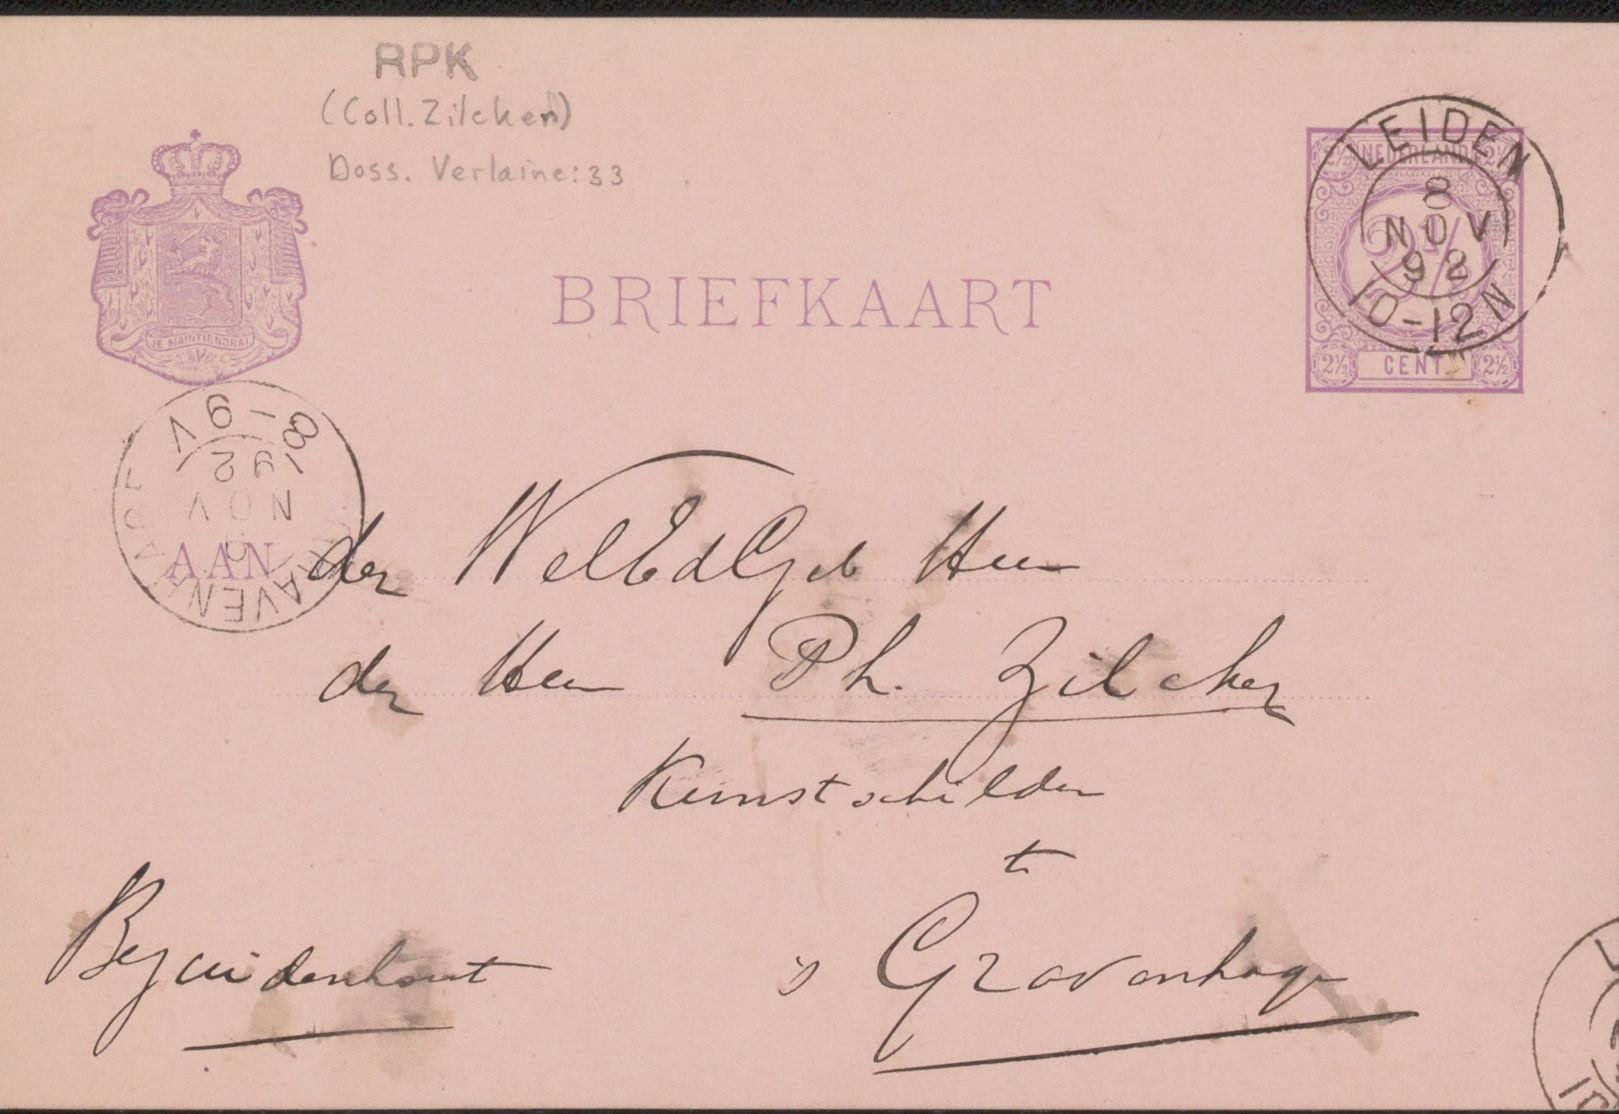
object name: postcard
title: Briefkaart aan Philip Zilcken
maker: cornelis willem hendrik verster van wulverhorst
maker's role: print maker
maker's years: 1862-1920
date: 1892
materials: cardboard, ink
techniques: pen, writing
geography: leiden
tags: paul verlaine, the hague, painter, draughtsman, philip zilcken, money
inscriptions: collector's mark: ‘RPK’